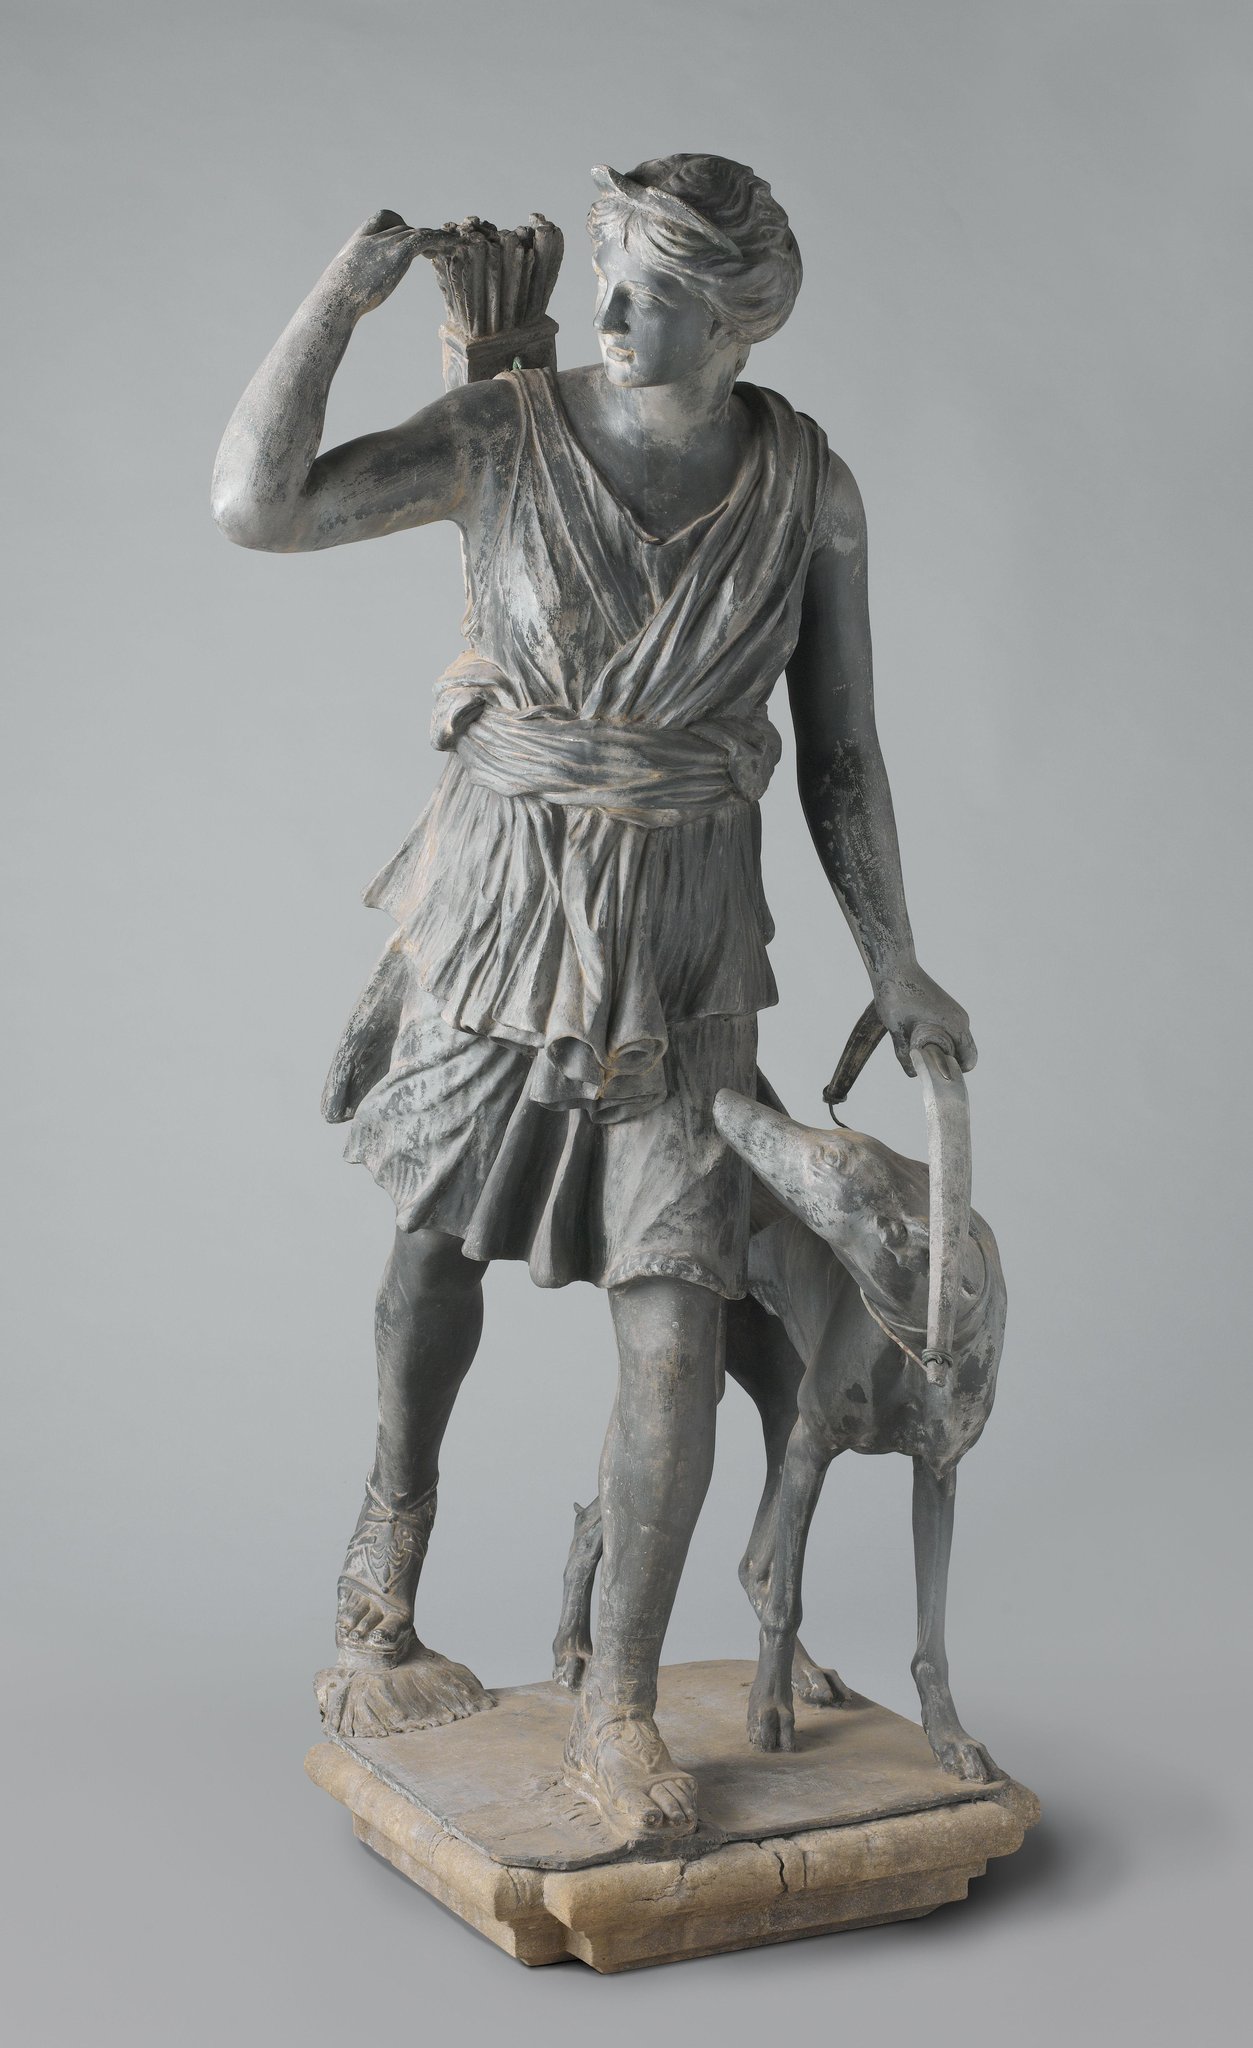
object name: tuinbeeld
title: Diana Hunting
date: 1700-1725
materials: lead, stone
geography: northern netherlands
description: Diana, goddess of the hunt, is shown here is full flow. The figure is based on a white marble Diana made in Ancient Rome which is now at the Louvre. This lead sculpture stood in a garden in the North Holland town of Monnickendam until around 1900.